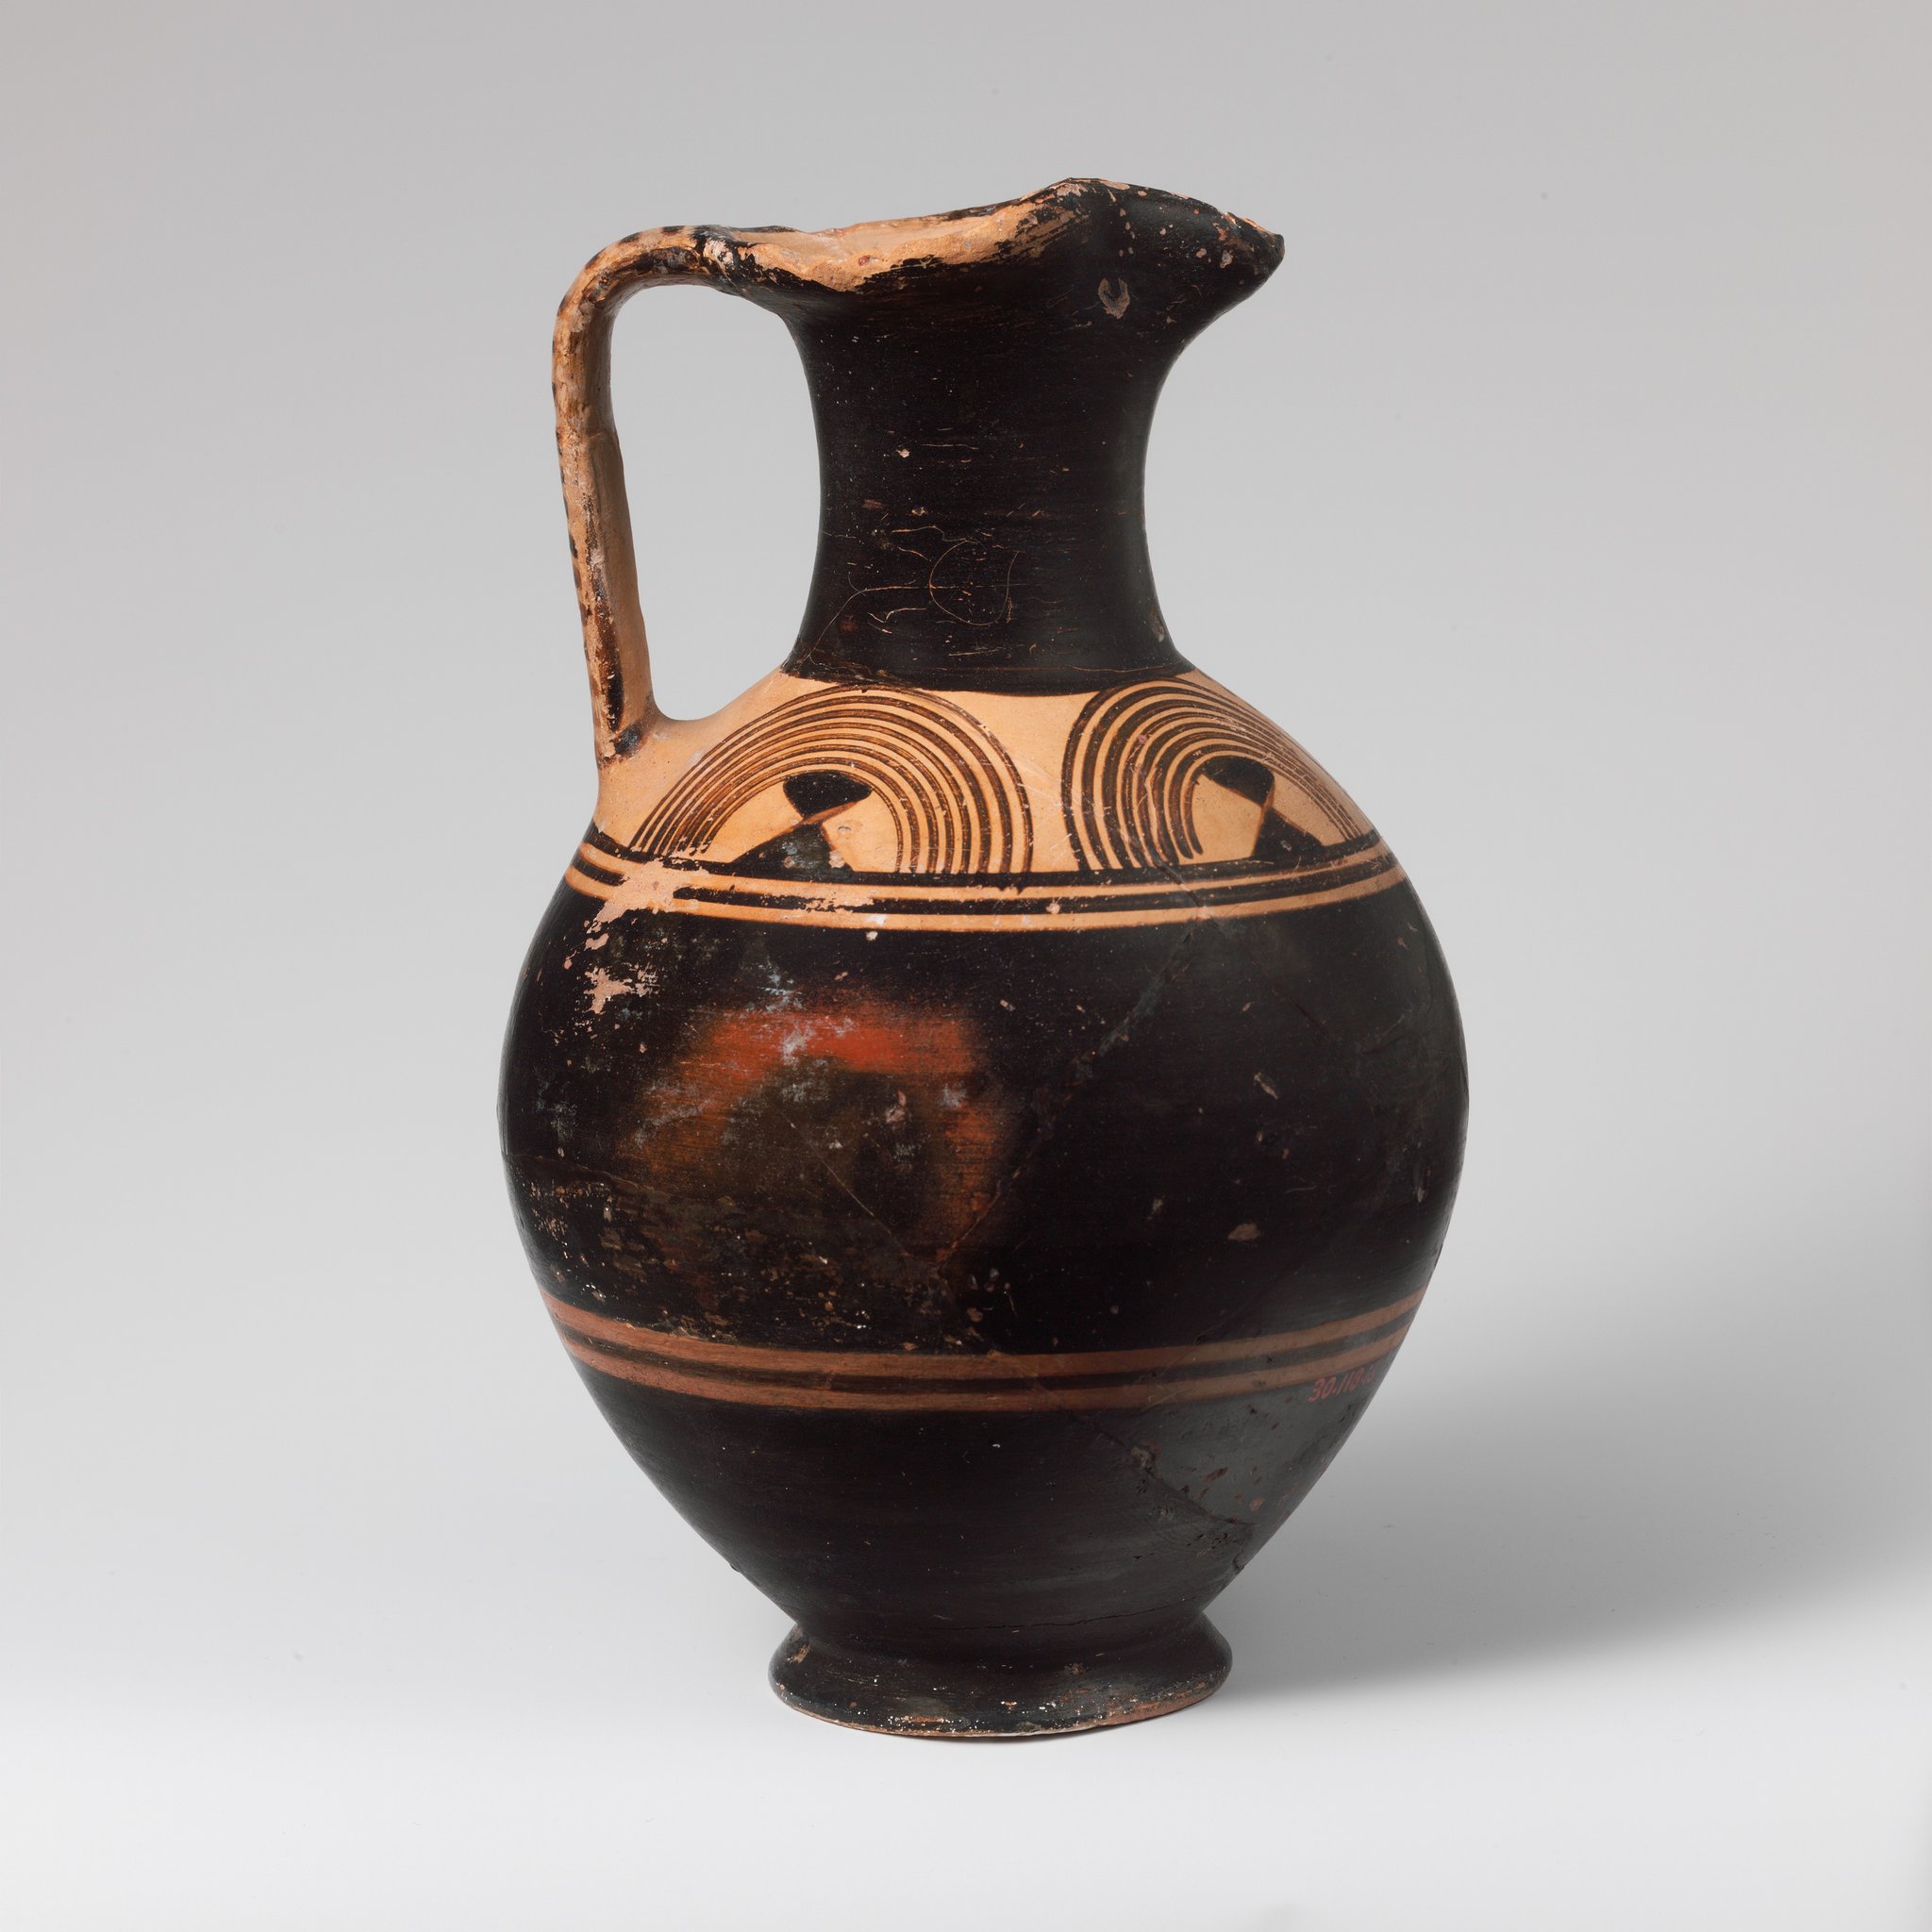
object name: oinochoe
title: Terracotta oinochoe (jug)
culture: greek, attic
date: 934-868 BCE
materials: terracotta